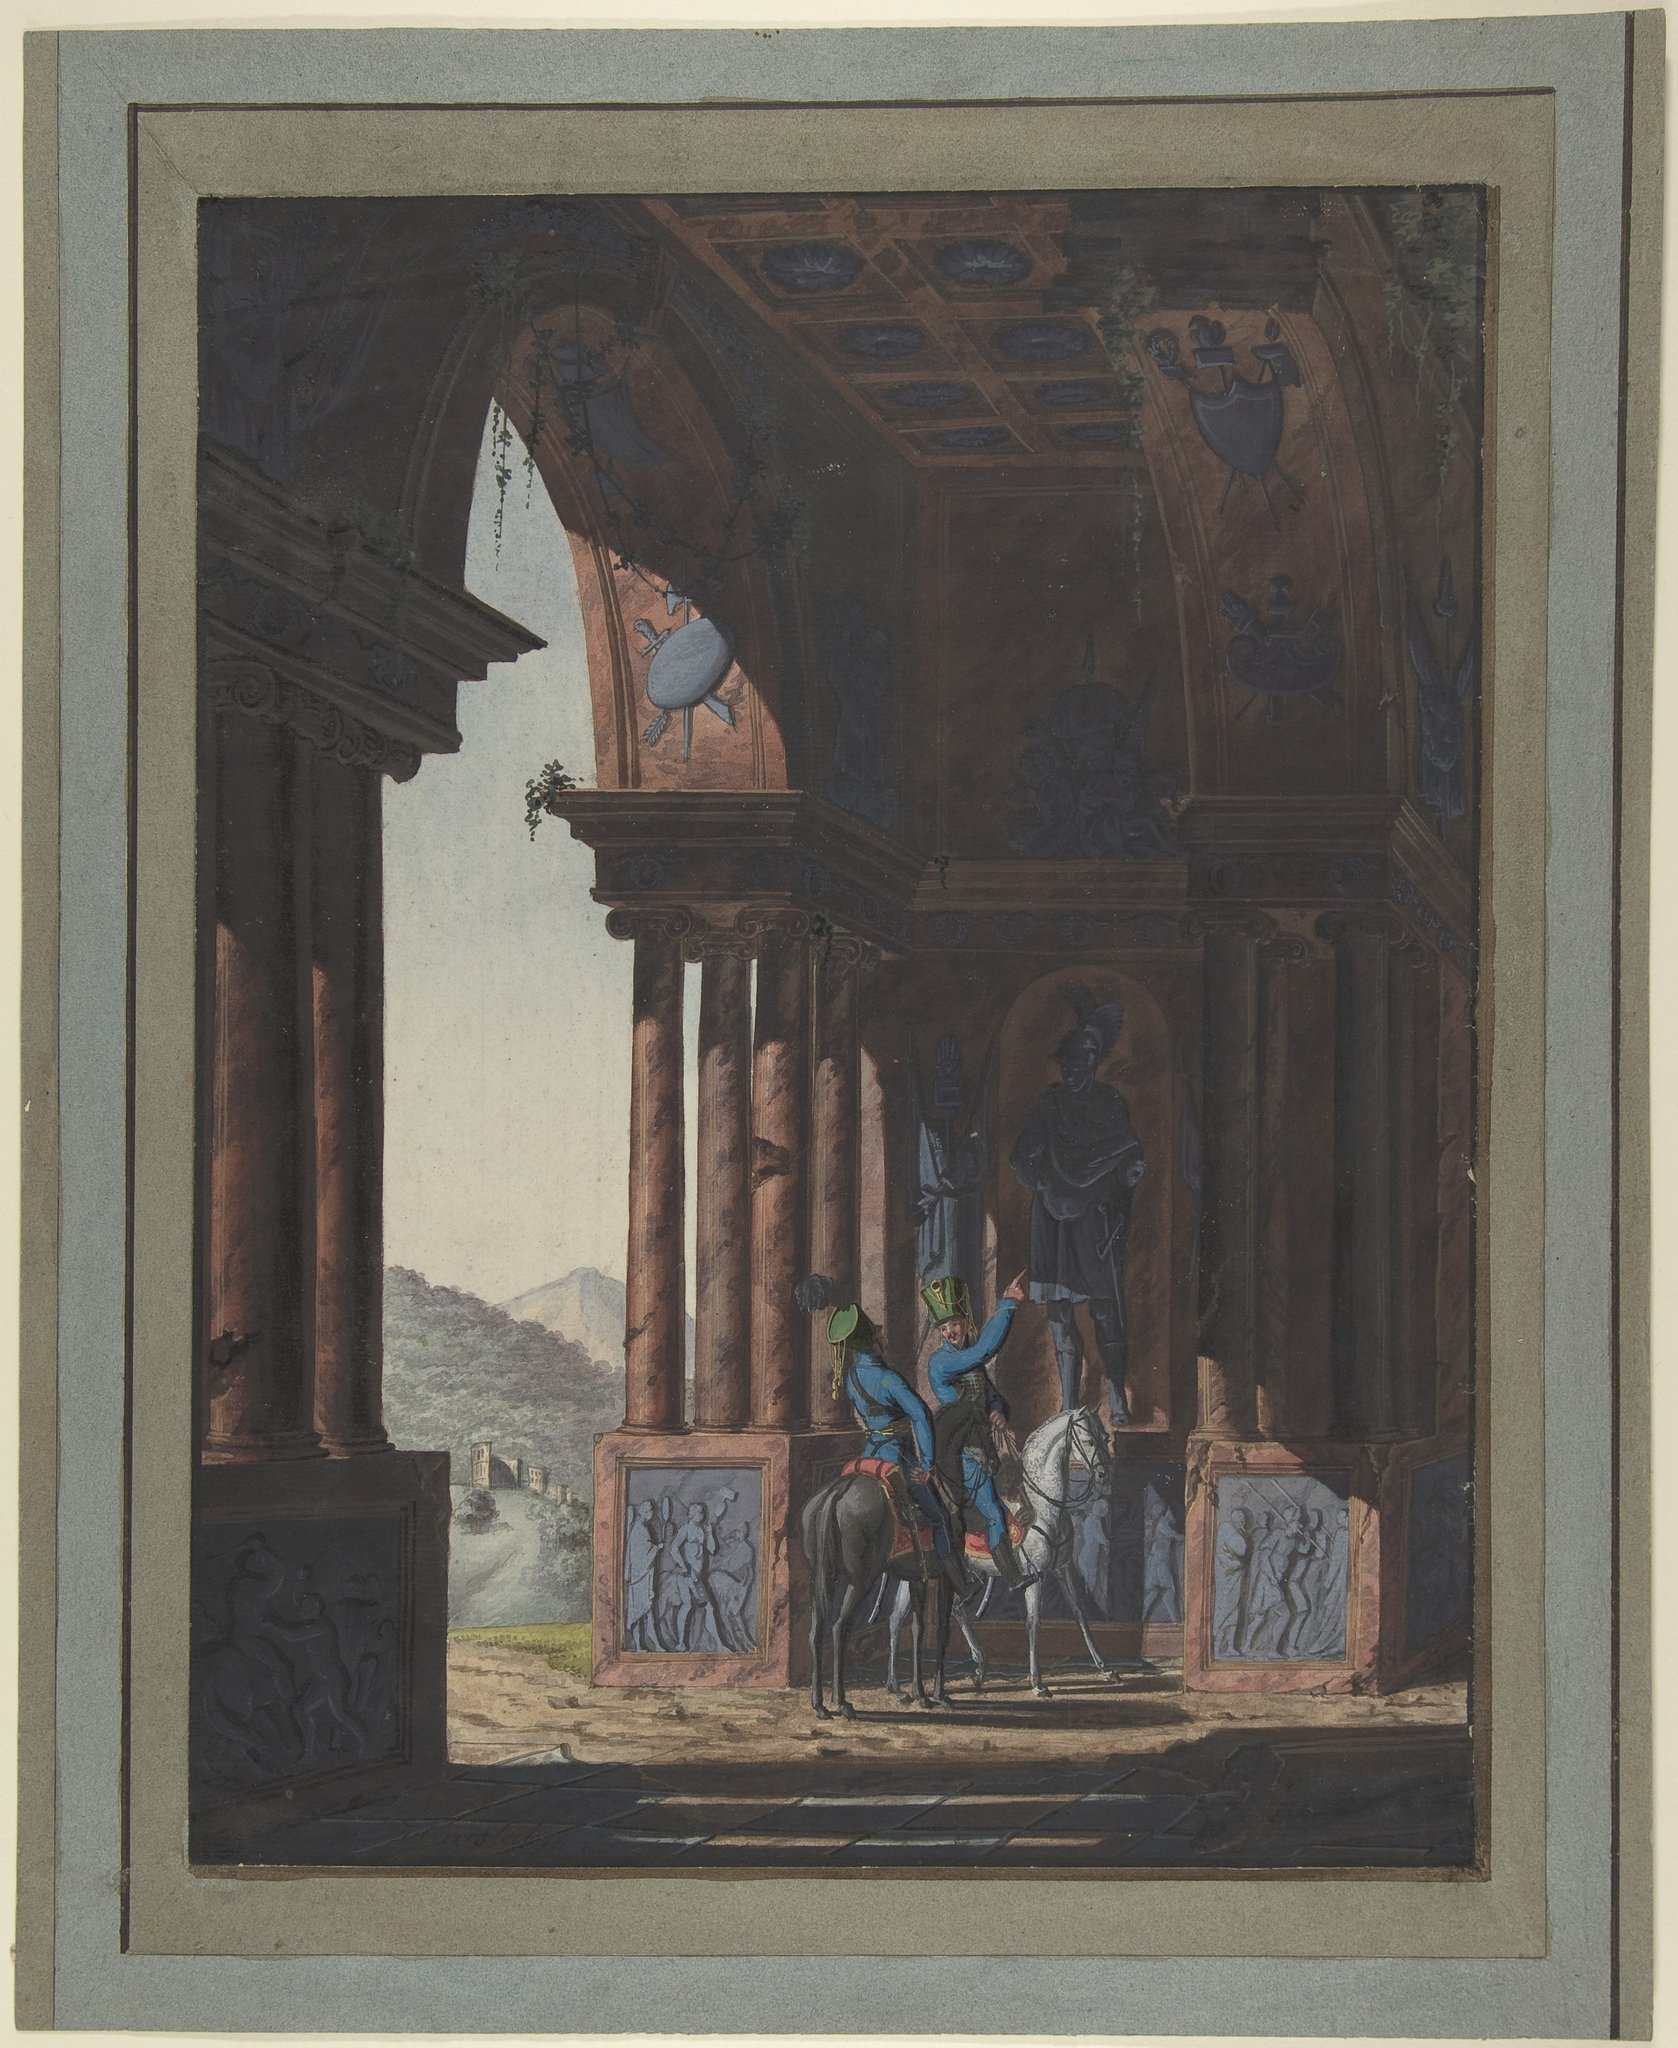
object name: drawing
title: Two Mounted Soldiers in Classical Ruins, for a poem by Cremes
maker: franz von hauslab the younger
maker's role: artist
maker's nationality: austrian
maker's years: 1798-1883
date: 1812-1883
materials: gouache, ink, watercolor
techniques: pen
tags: ruins,soldiers,horses